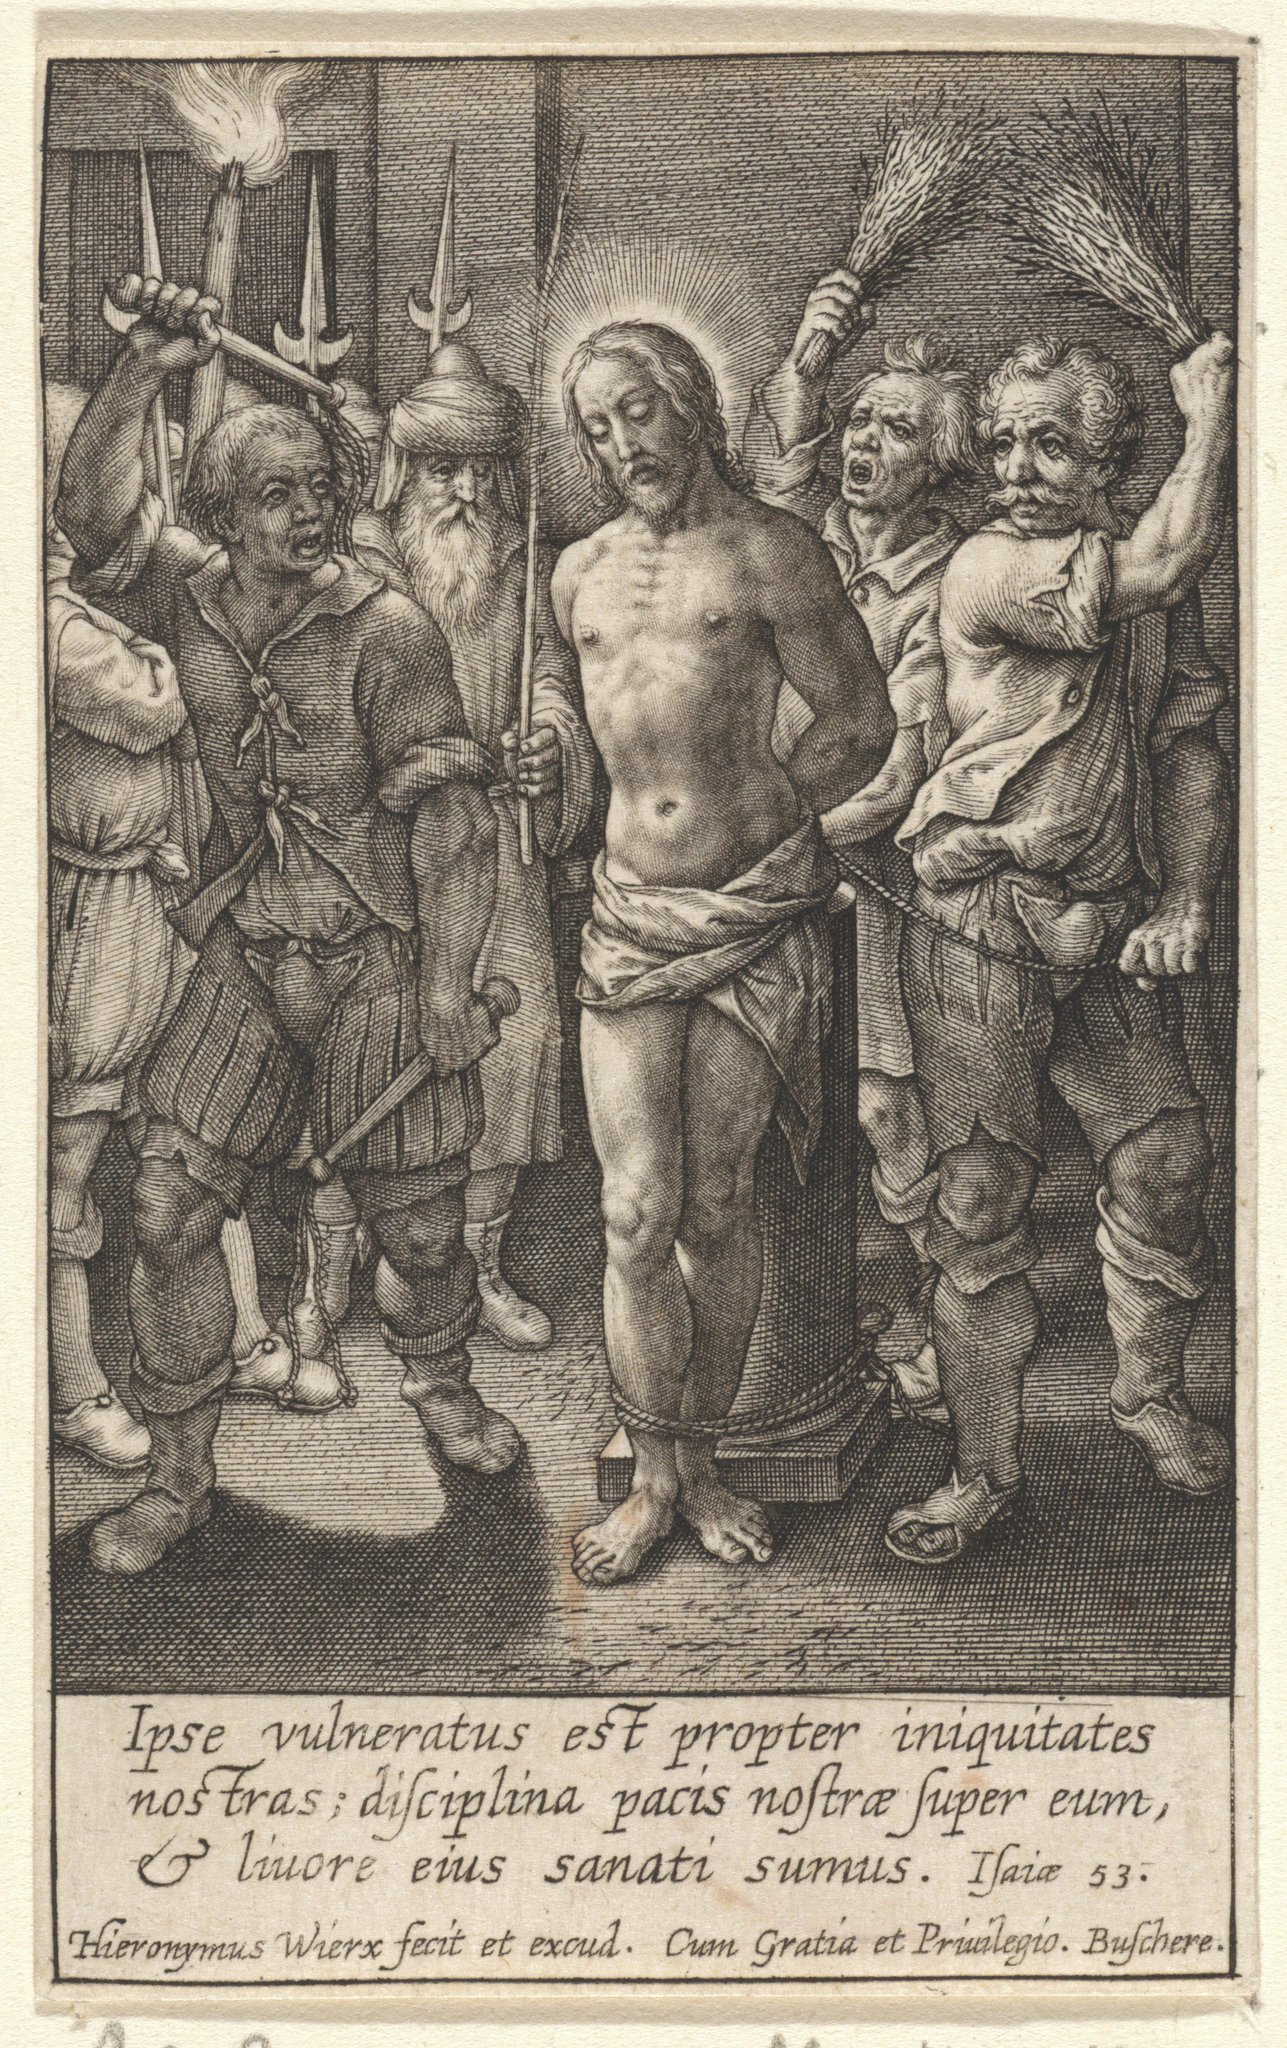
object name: print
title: Geseling van Christus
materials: paper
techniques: engraving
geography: antwerp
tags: flagellation by soldiers, christ usually tied to a column (matthew 27:26; mark 15:15; john 19:1)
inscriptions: collector's mark: Lugt 240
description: De aan een pilaar gebonden Christus wordt door soldaten gegeseld. Op de achtergrond kijkt Pilatus toe. In de marge een drieregelig Bijbelcitaat uit Jes. 53 in het Latijn.